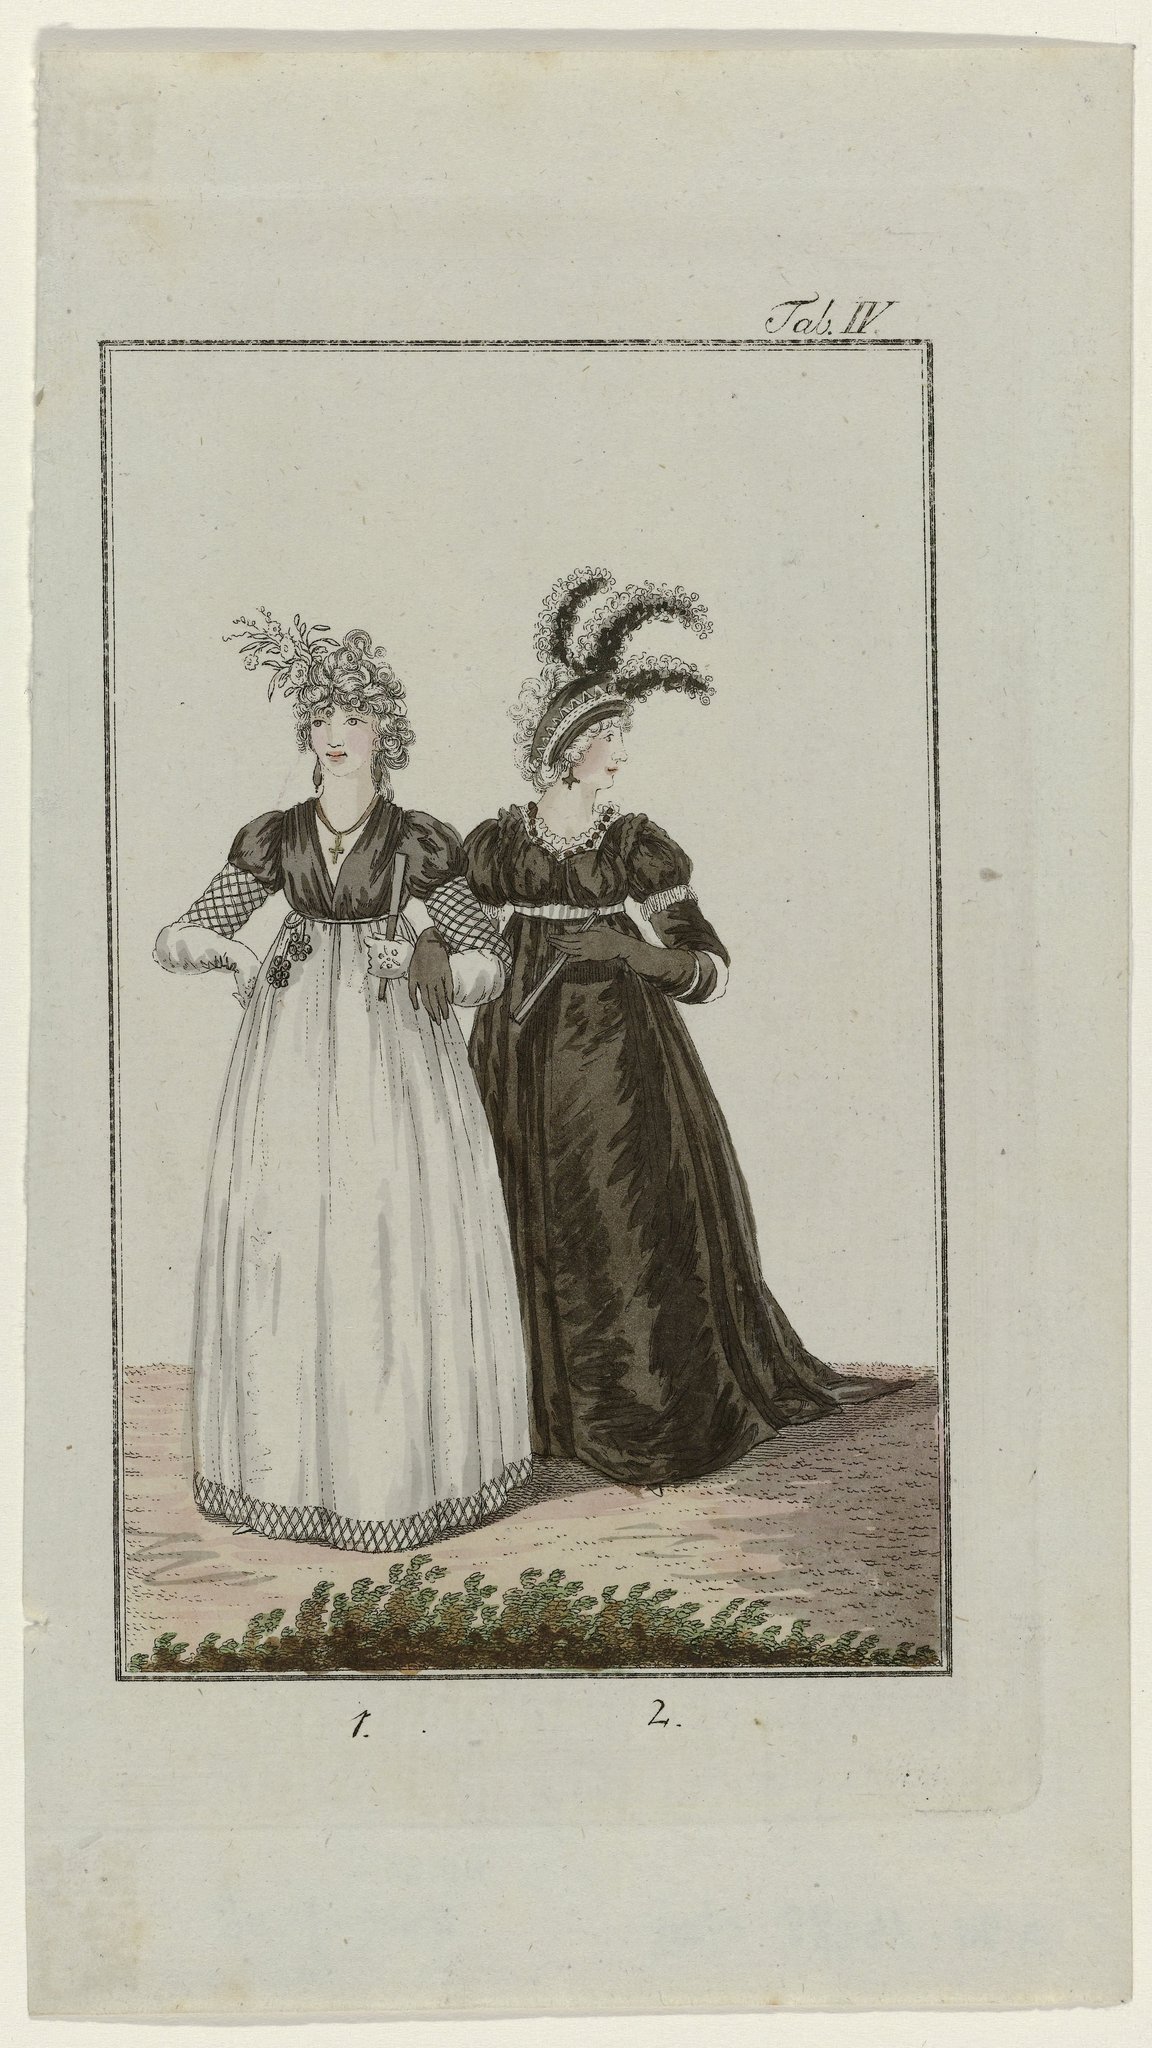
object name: fashion print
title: Journal für Fabrik, Manufaktur, Handlung, Kunst und Mode, 1798, Tab IV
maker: Anonymous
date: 1798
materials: paper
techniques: etching, hand coloring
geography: leipzig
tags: ear-rings (+ women's clothes), gloves, mittens (long gloves) (+ women's clothes), head-gear (+ women's clothes), fashion plates, dress, gown (+ women's clothes), fan (+ women's clothes), necklace (+ women's clothes)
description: Twee staande vrouwen, gearmd, gekleed in japonnen met hoge taille en halflange mouwen. Links (nr. 1): het kapsel versierd met bloemen. Accessoires: oorbellen, collier met kruis, ceintuur, lange handschoenen, waaier. Rechts (nr. 2): in het haar een haarband met veren. Verdere accessoires: oorbel in het rechteroor, collier, ceintuur, lange handschoenen, waaier. Uit het modetijdschrift Journal für Fabrik, Manufaktur, Handlung, Kunst und Mode, 1791-1808. De figuren zijn waarschijnlijk overgenomen uit het modetijdschrift Gallery of Fashion, uitgegeven door Nicolaus Heideloff, Londen, 1794-1803.